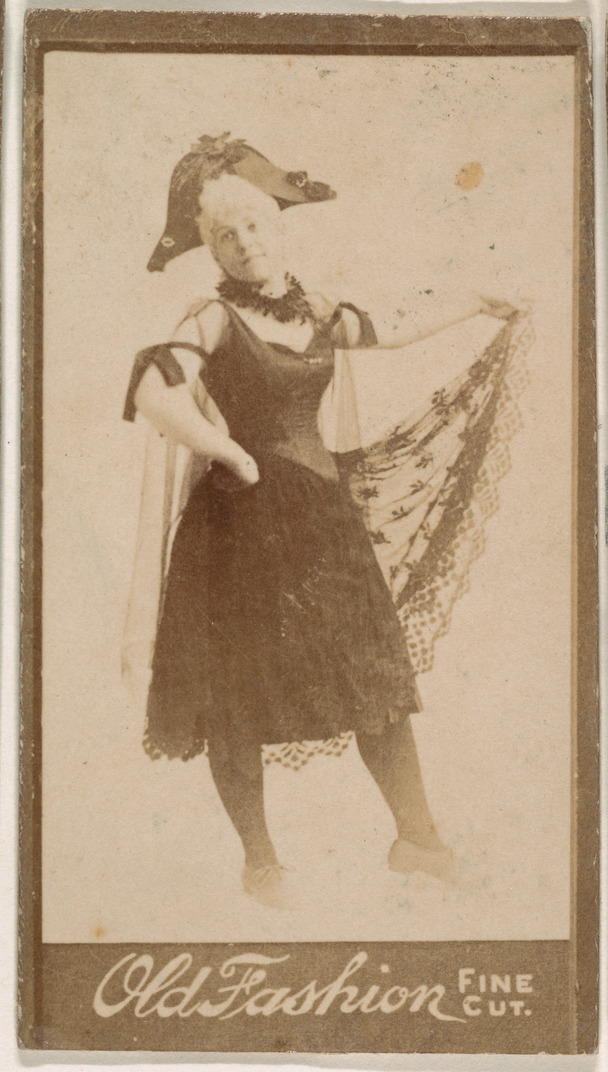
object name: photograph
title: Dancer, from the Actresses series (N664) promoting Old Fashion Fine Cut Tobacco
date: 1888-1890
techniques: albumen silver print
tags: portraits,women,dancers